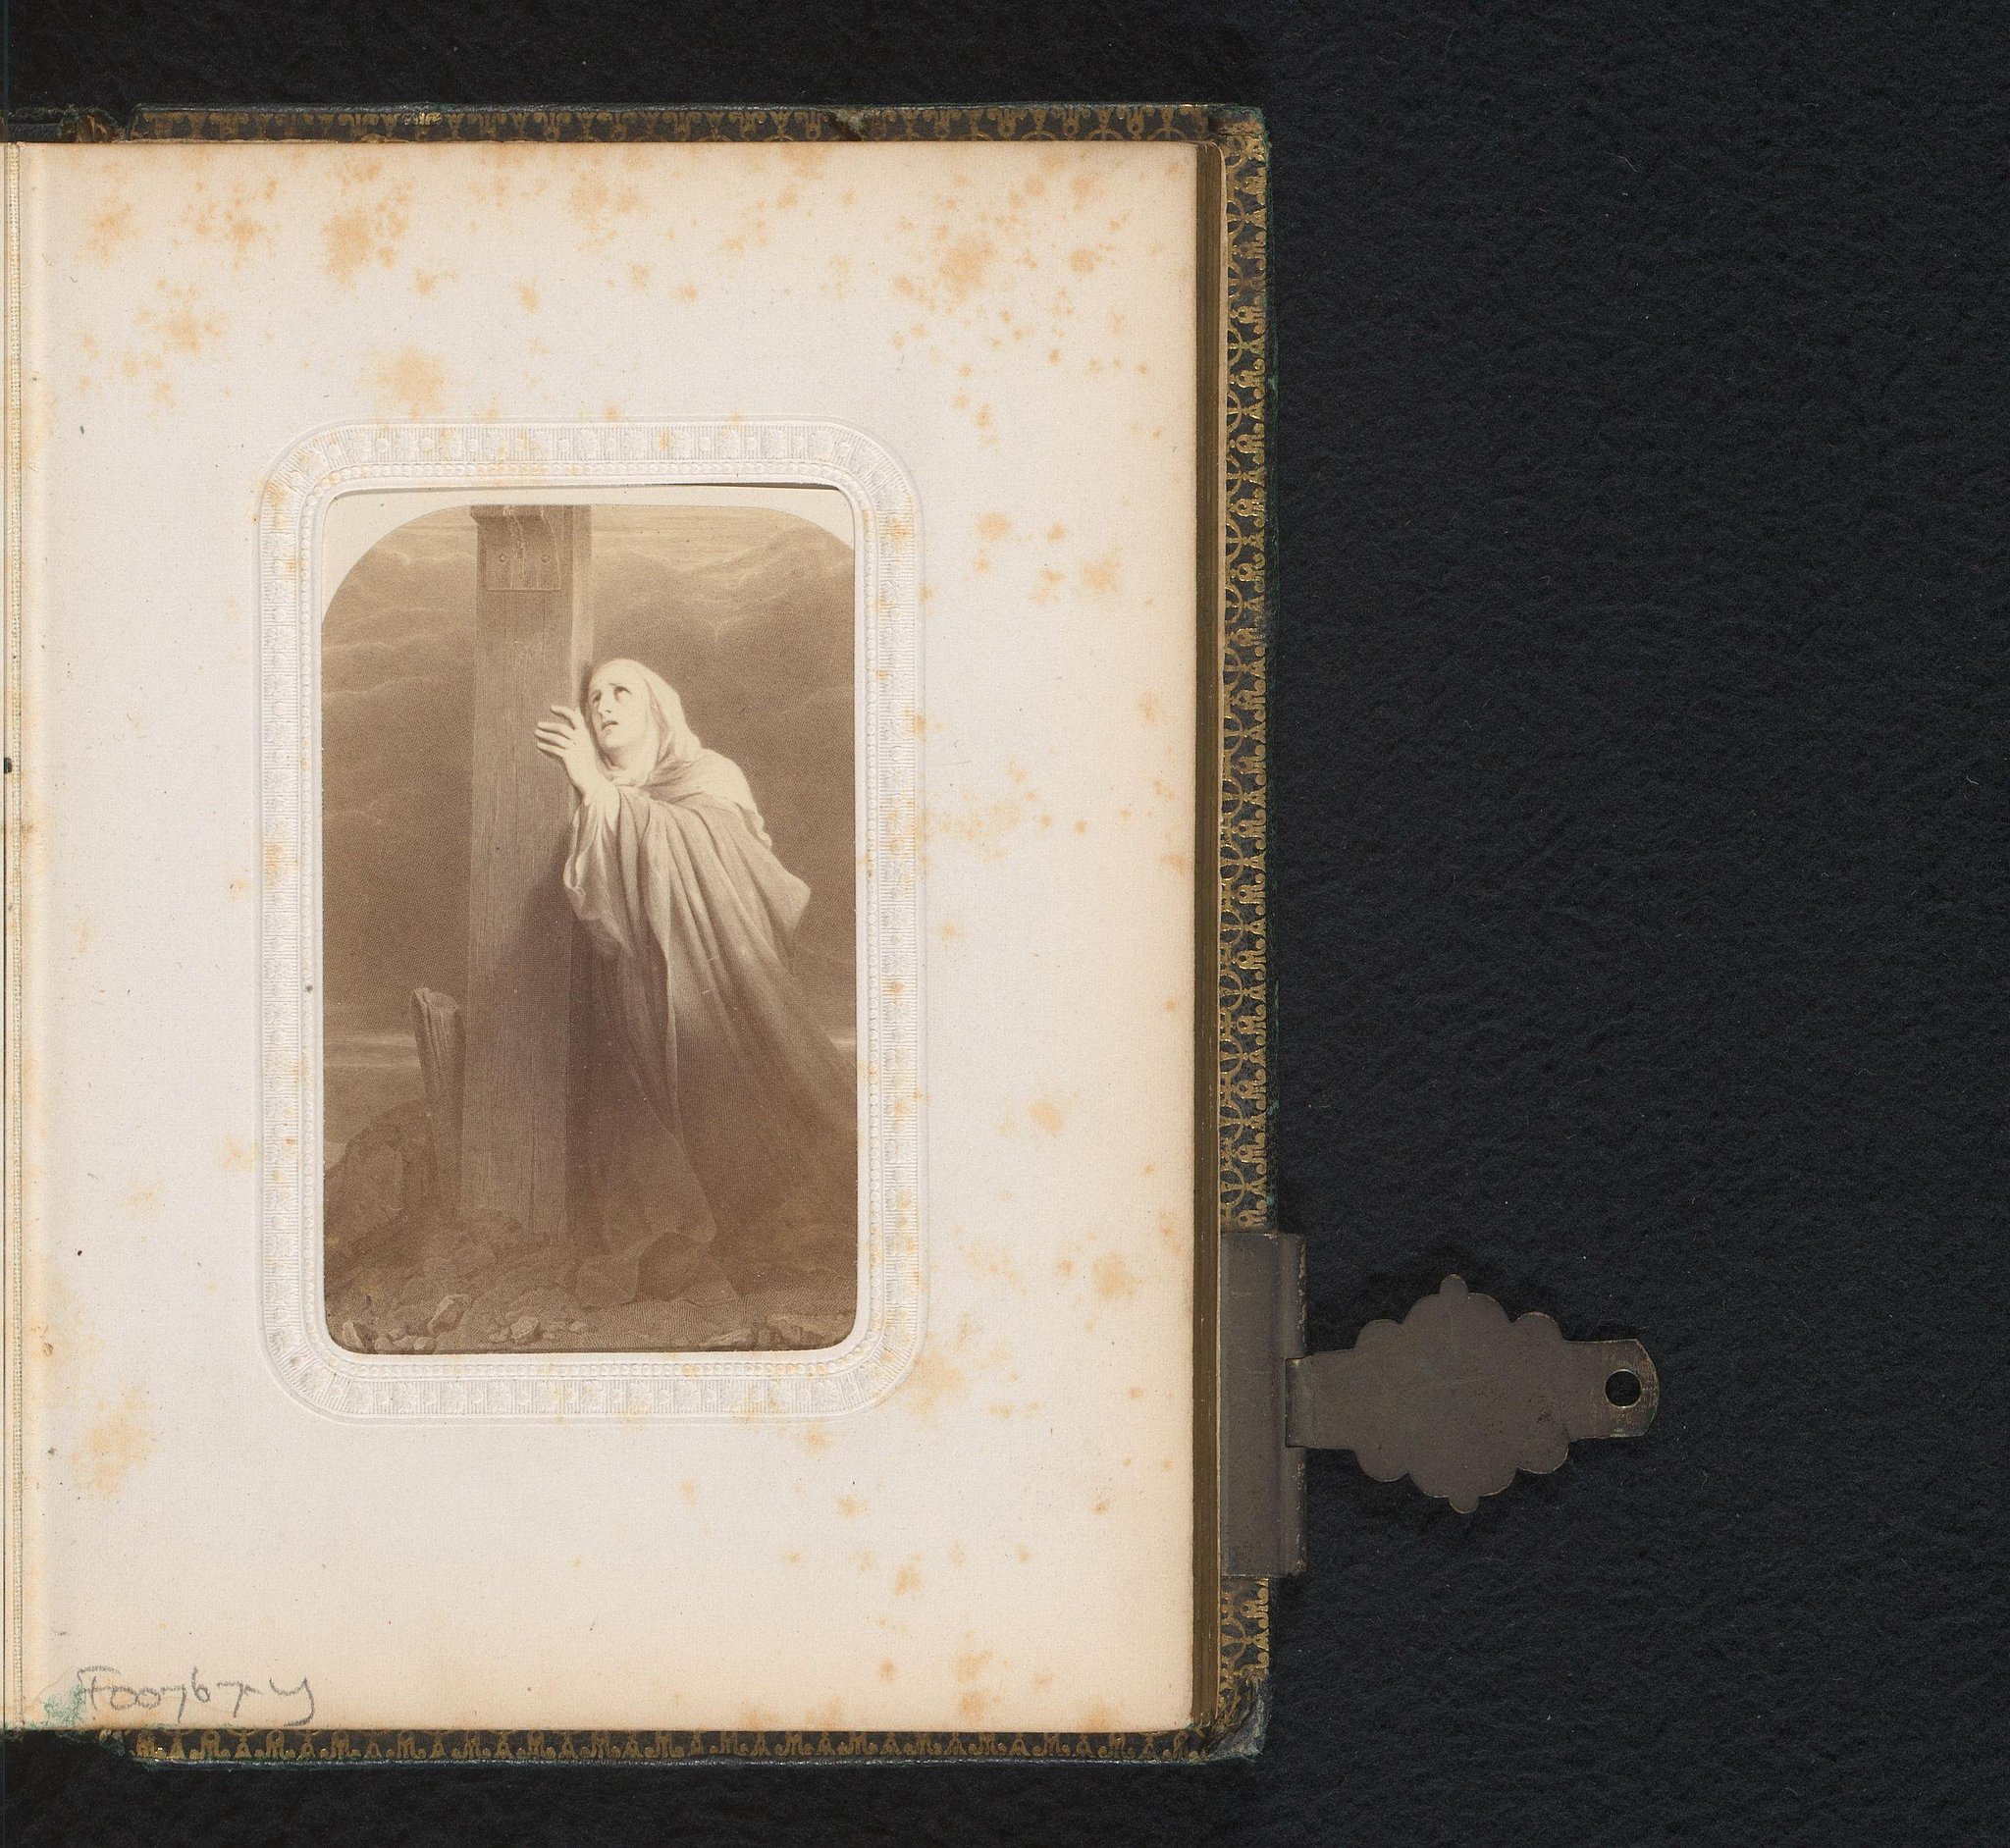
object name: carte de visite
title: Fotoreproductie van een schilderij van Maria onder het kruis door Paul Delaroche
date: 1861-1878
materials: cardboard, photographic support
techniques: albumen print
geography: paris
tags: crucified christ with mary magdalene, who usually weeps and embraces the cross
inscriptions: inscription: ‘PHOTOGRAPHIE GOUPIL & Cie/ PARIS, 19, Bd Montmartre./ LONDRES-LA HAYE-BERLIN-NEW YORK’